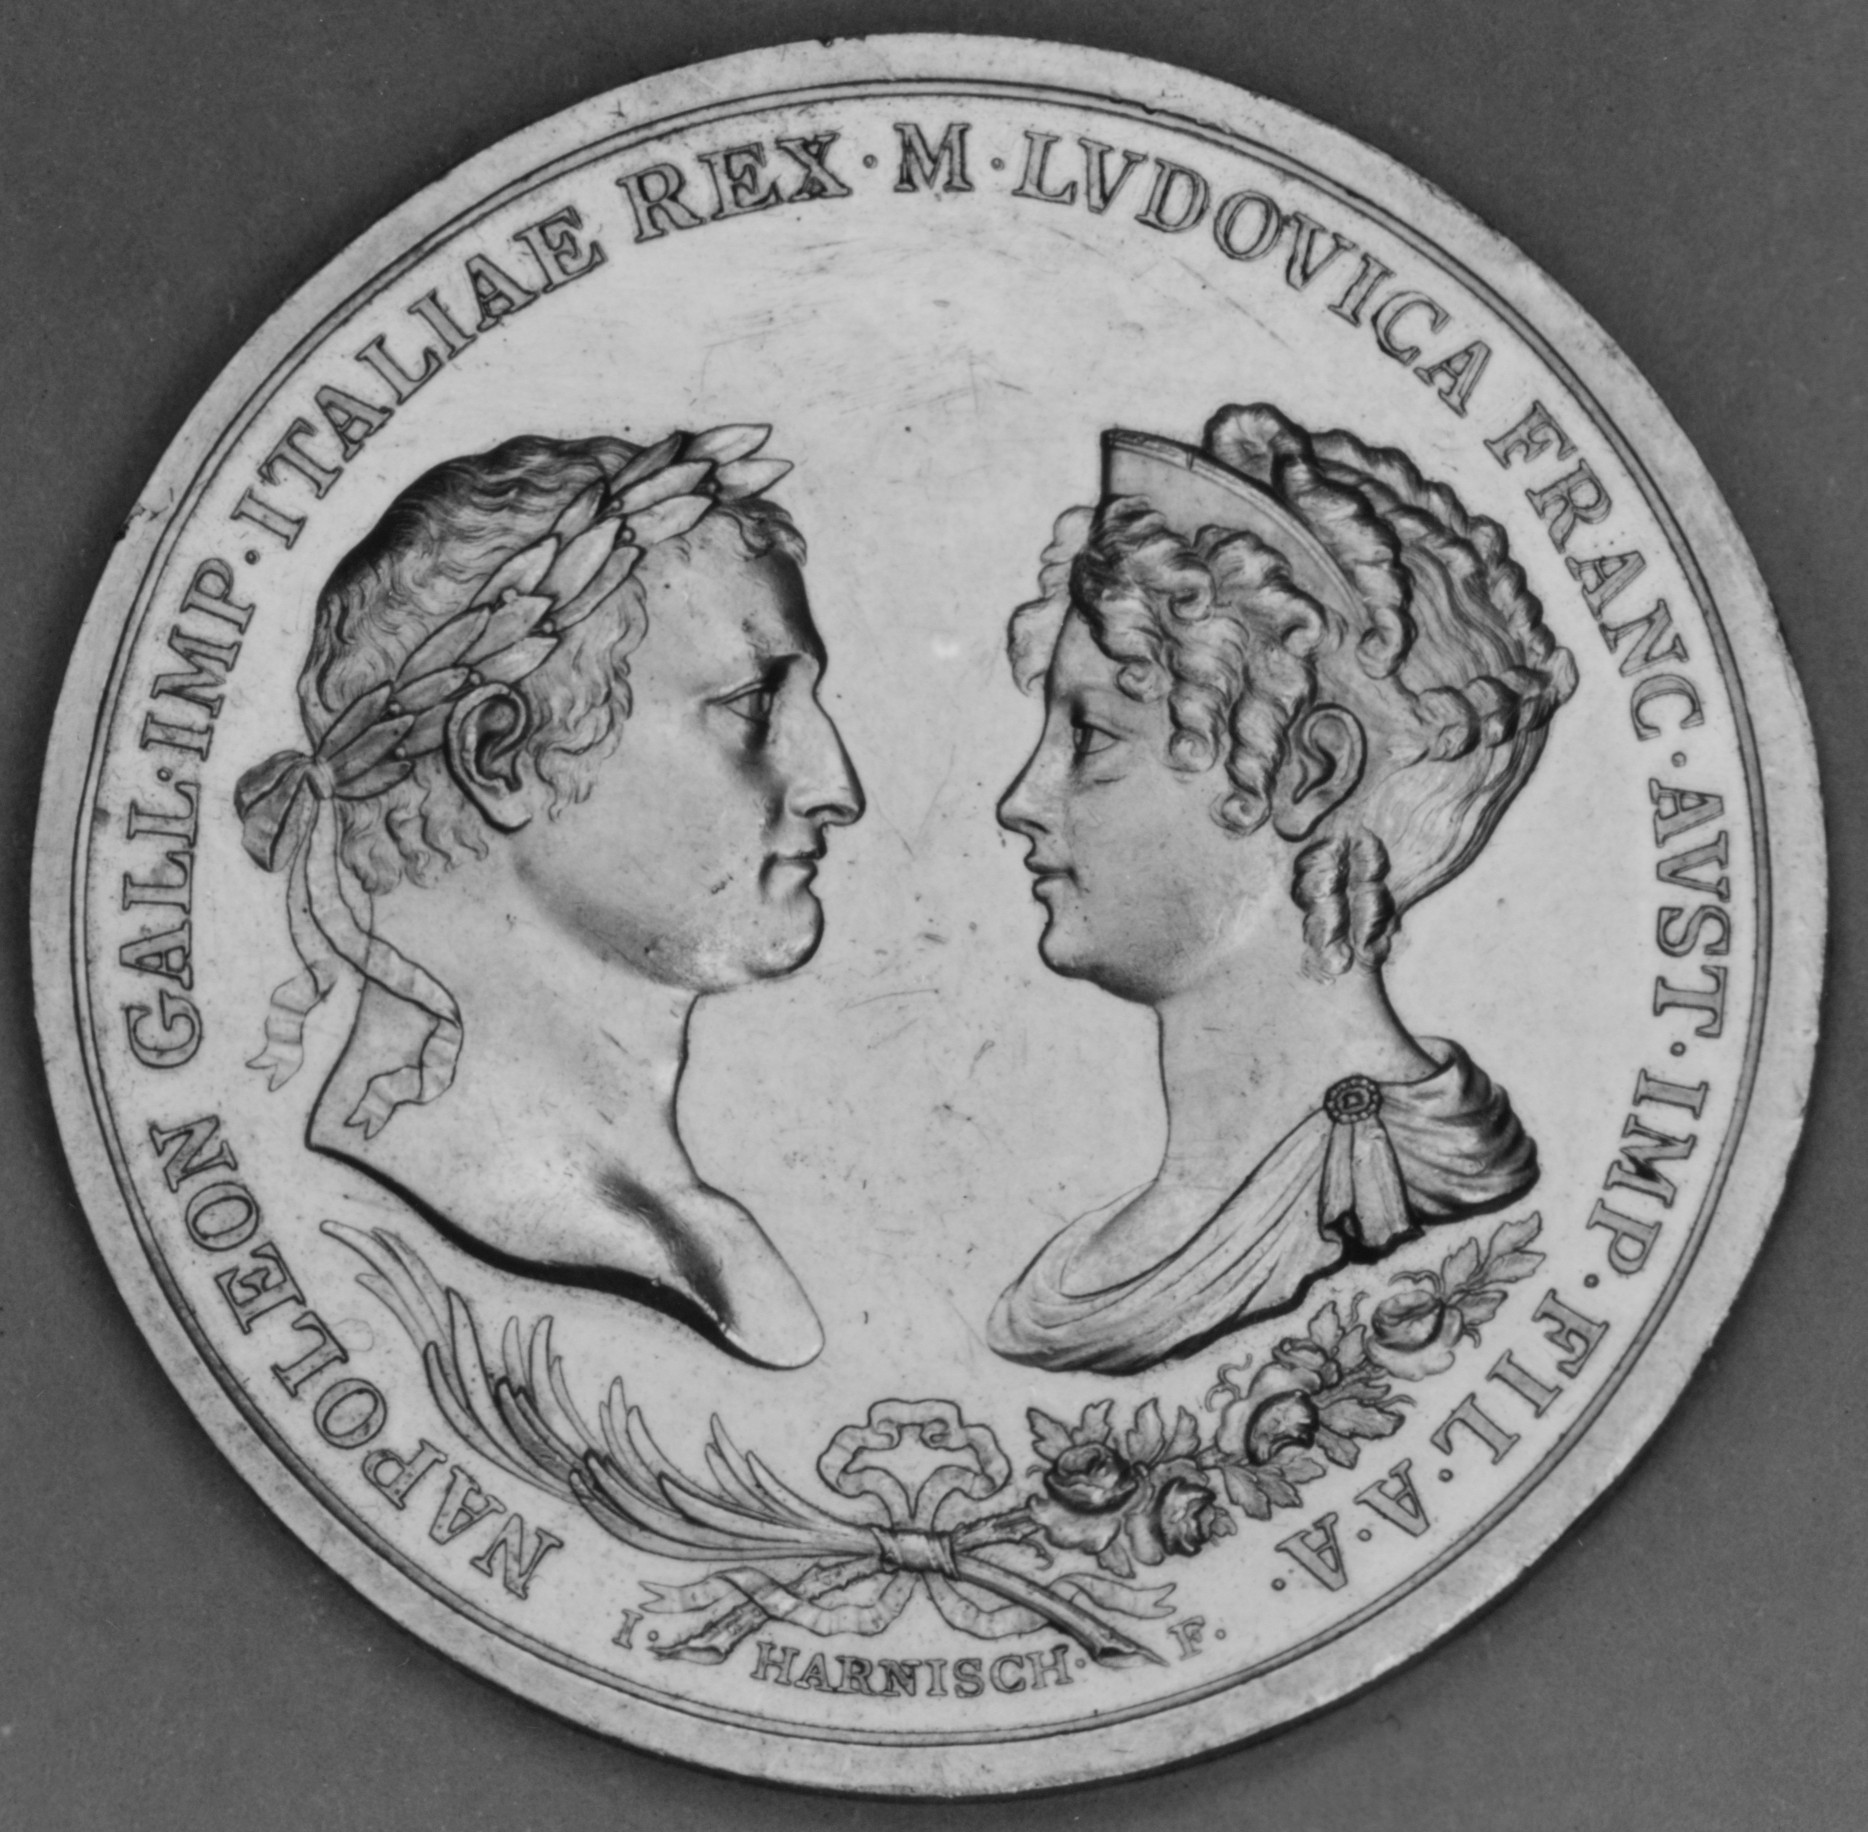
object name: medal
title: Commemorating Marriage of Napoleon and Marie Louise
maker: johann baptist harnisch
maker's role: artist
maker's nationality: austrian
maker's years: 1785-1833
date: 1810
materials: gold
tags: men,profiles,women